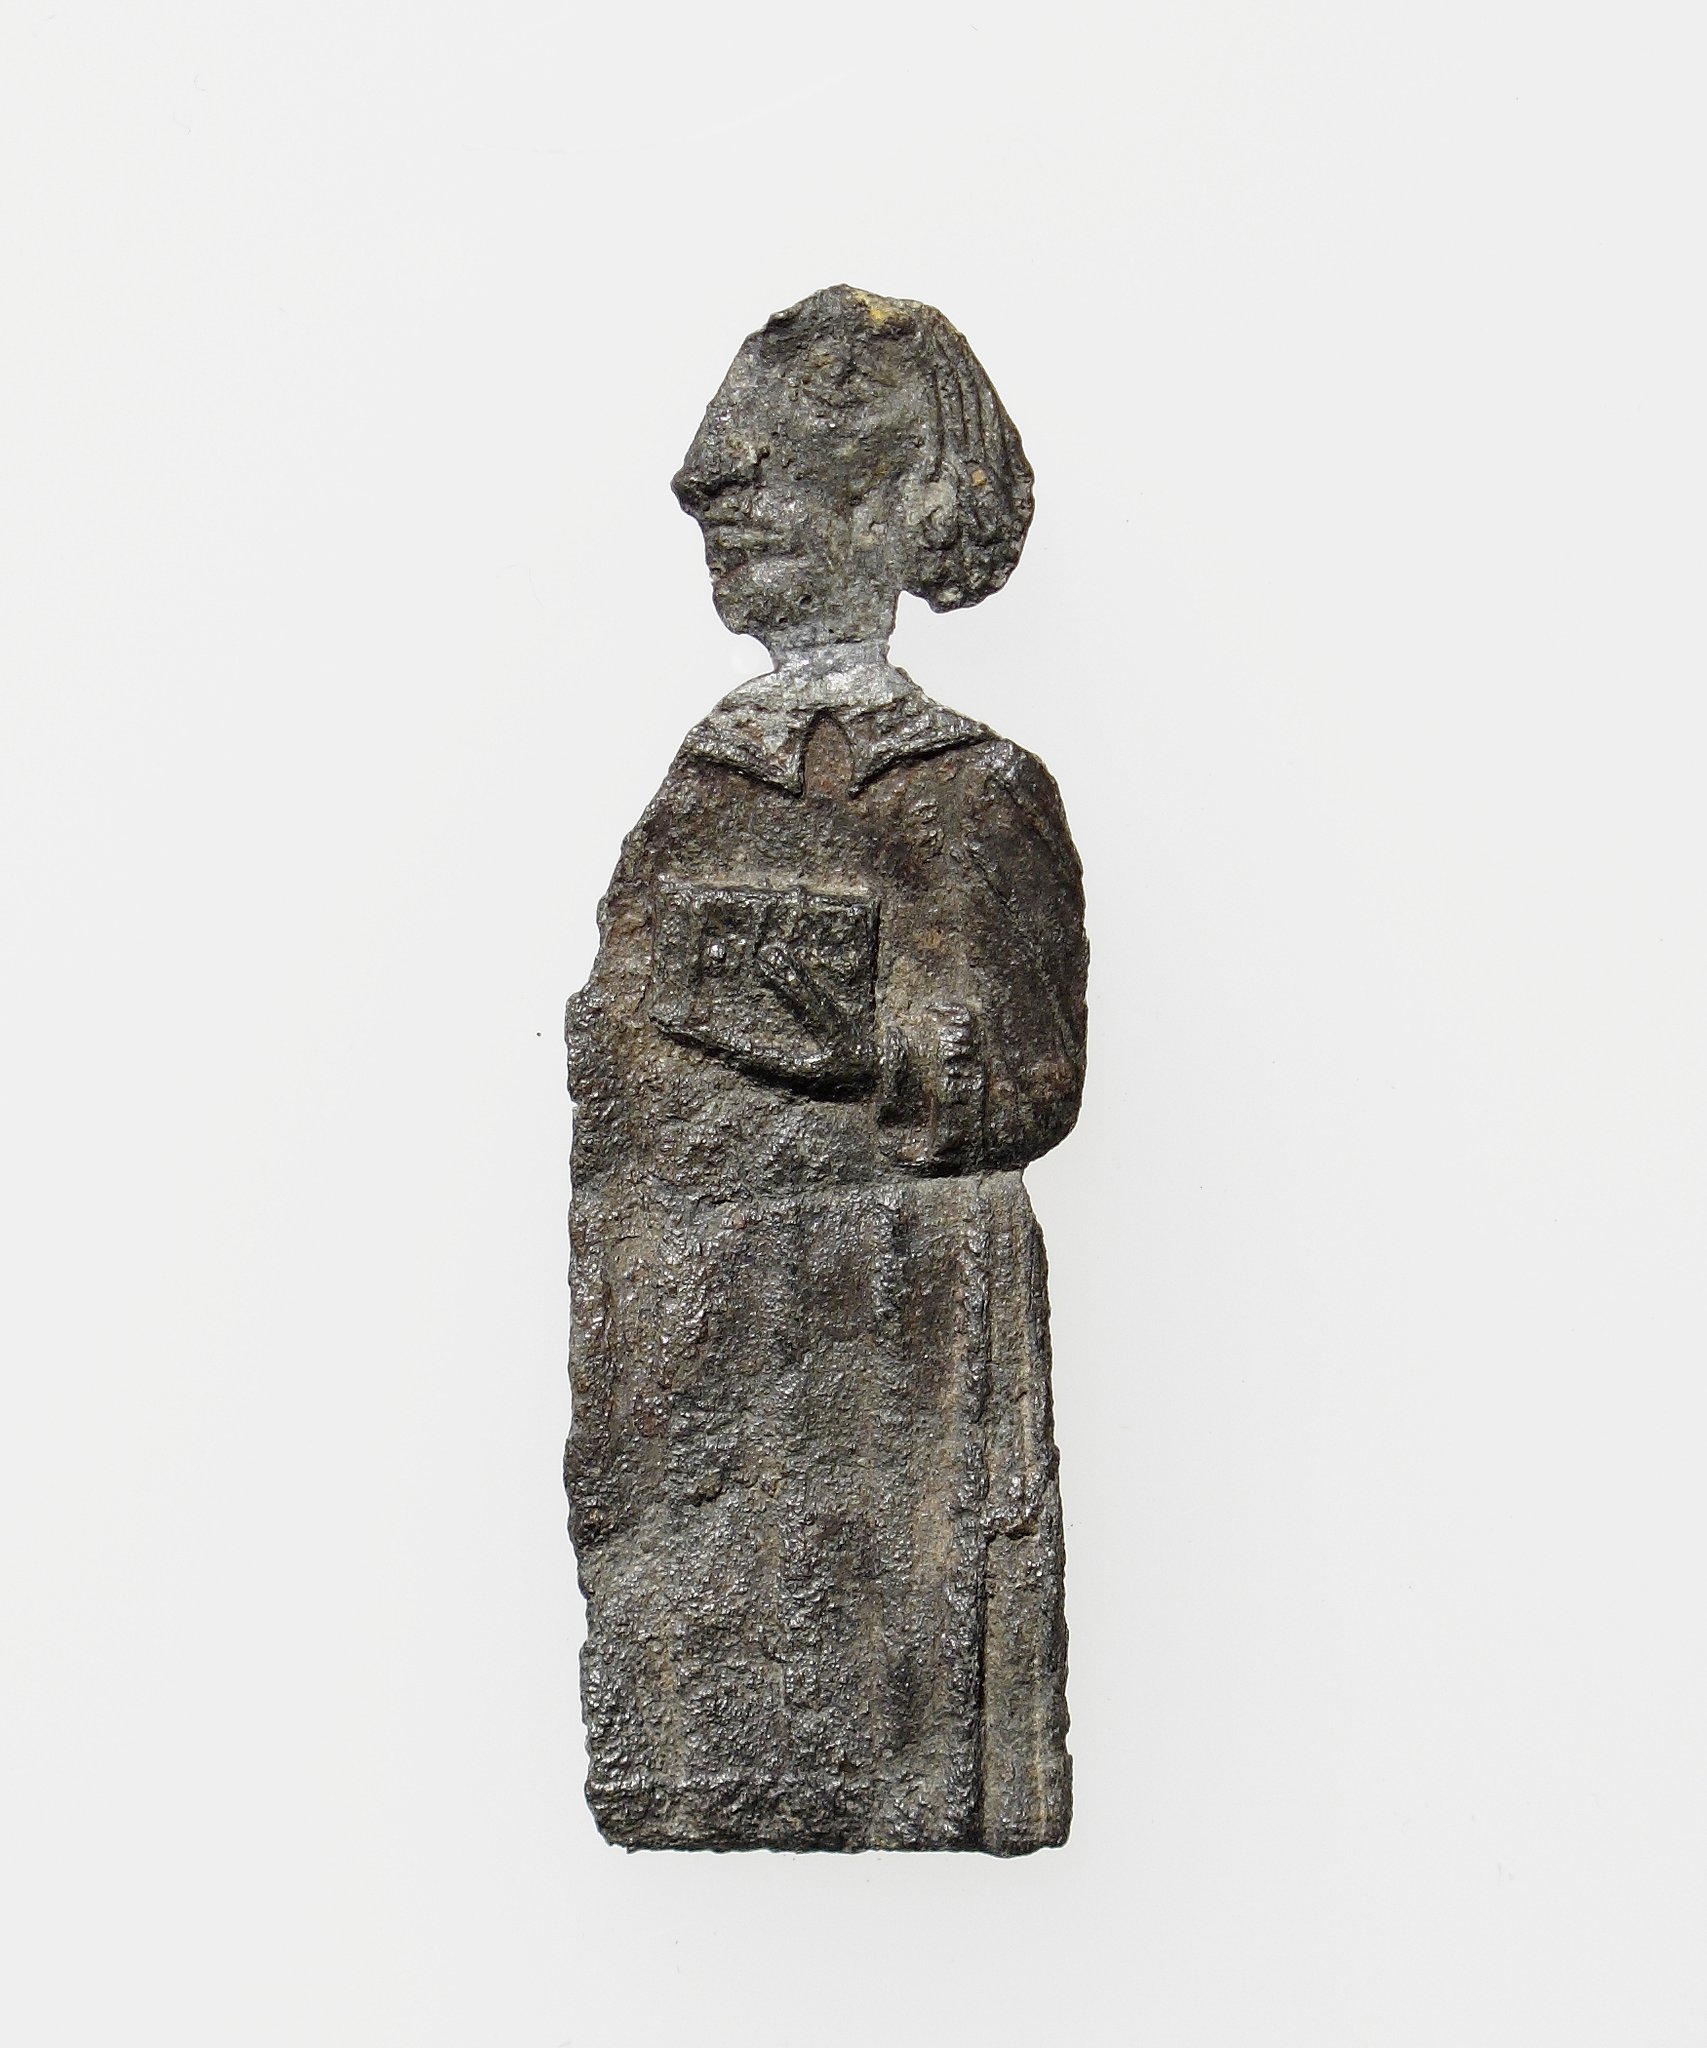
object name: pilgrim's badge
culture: french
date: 1301-1600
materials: lead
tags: men